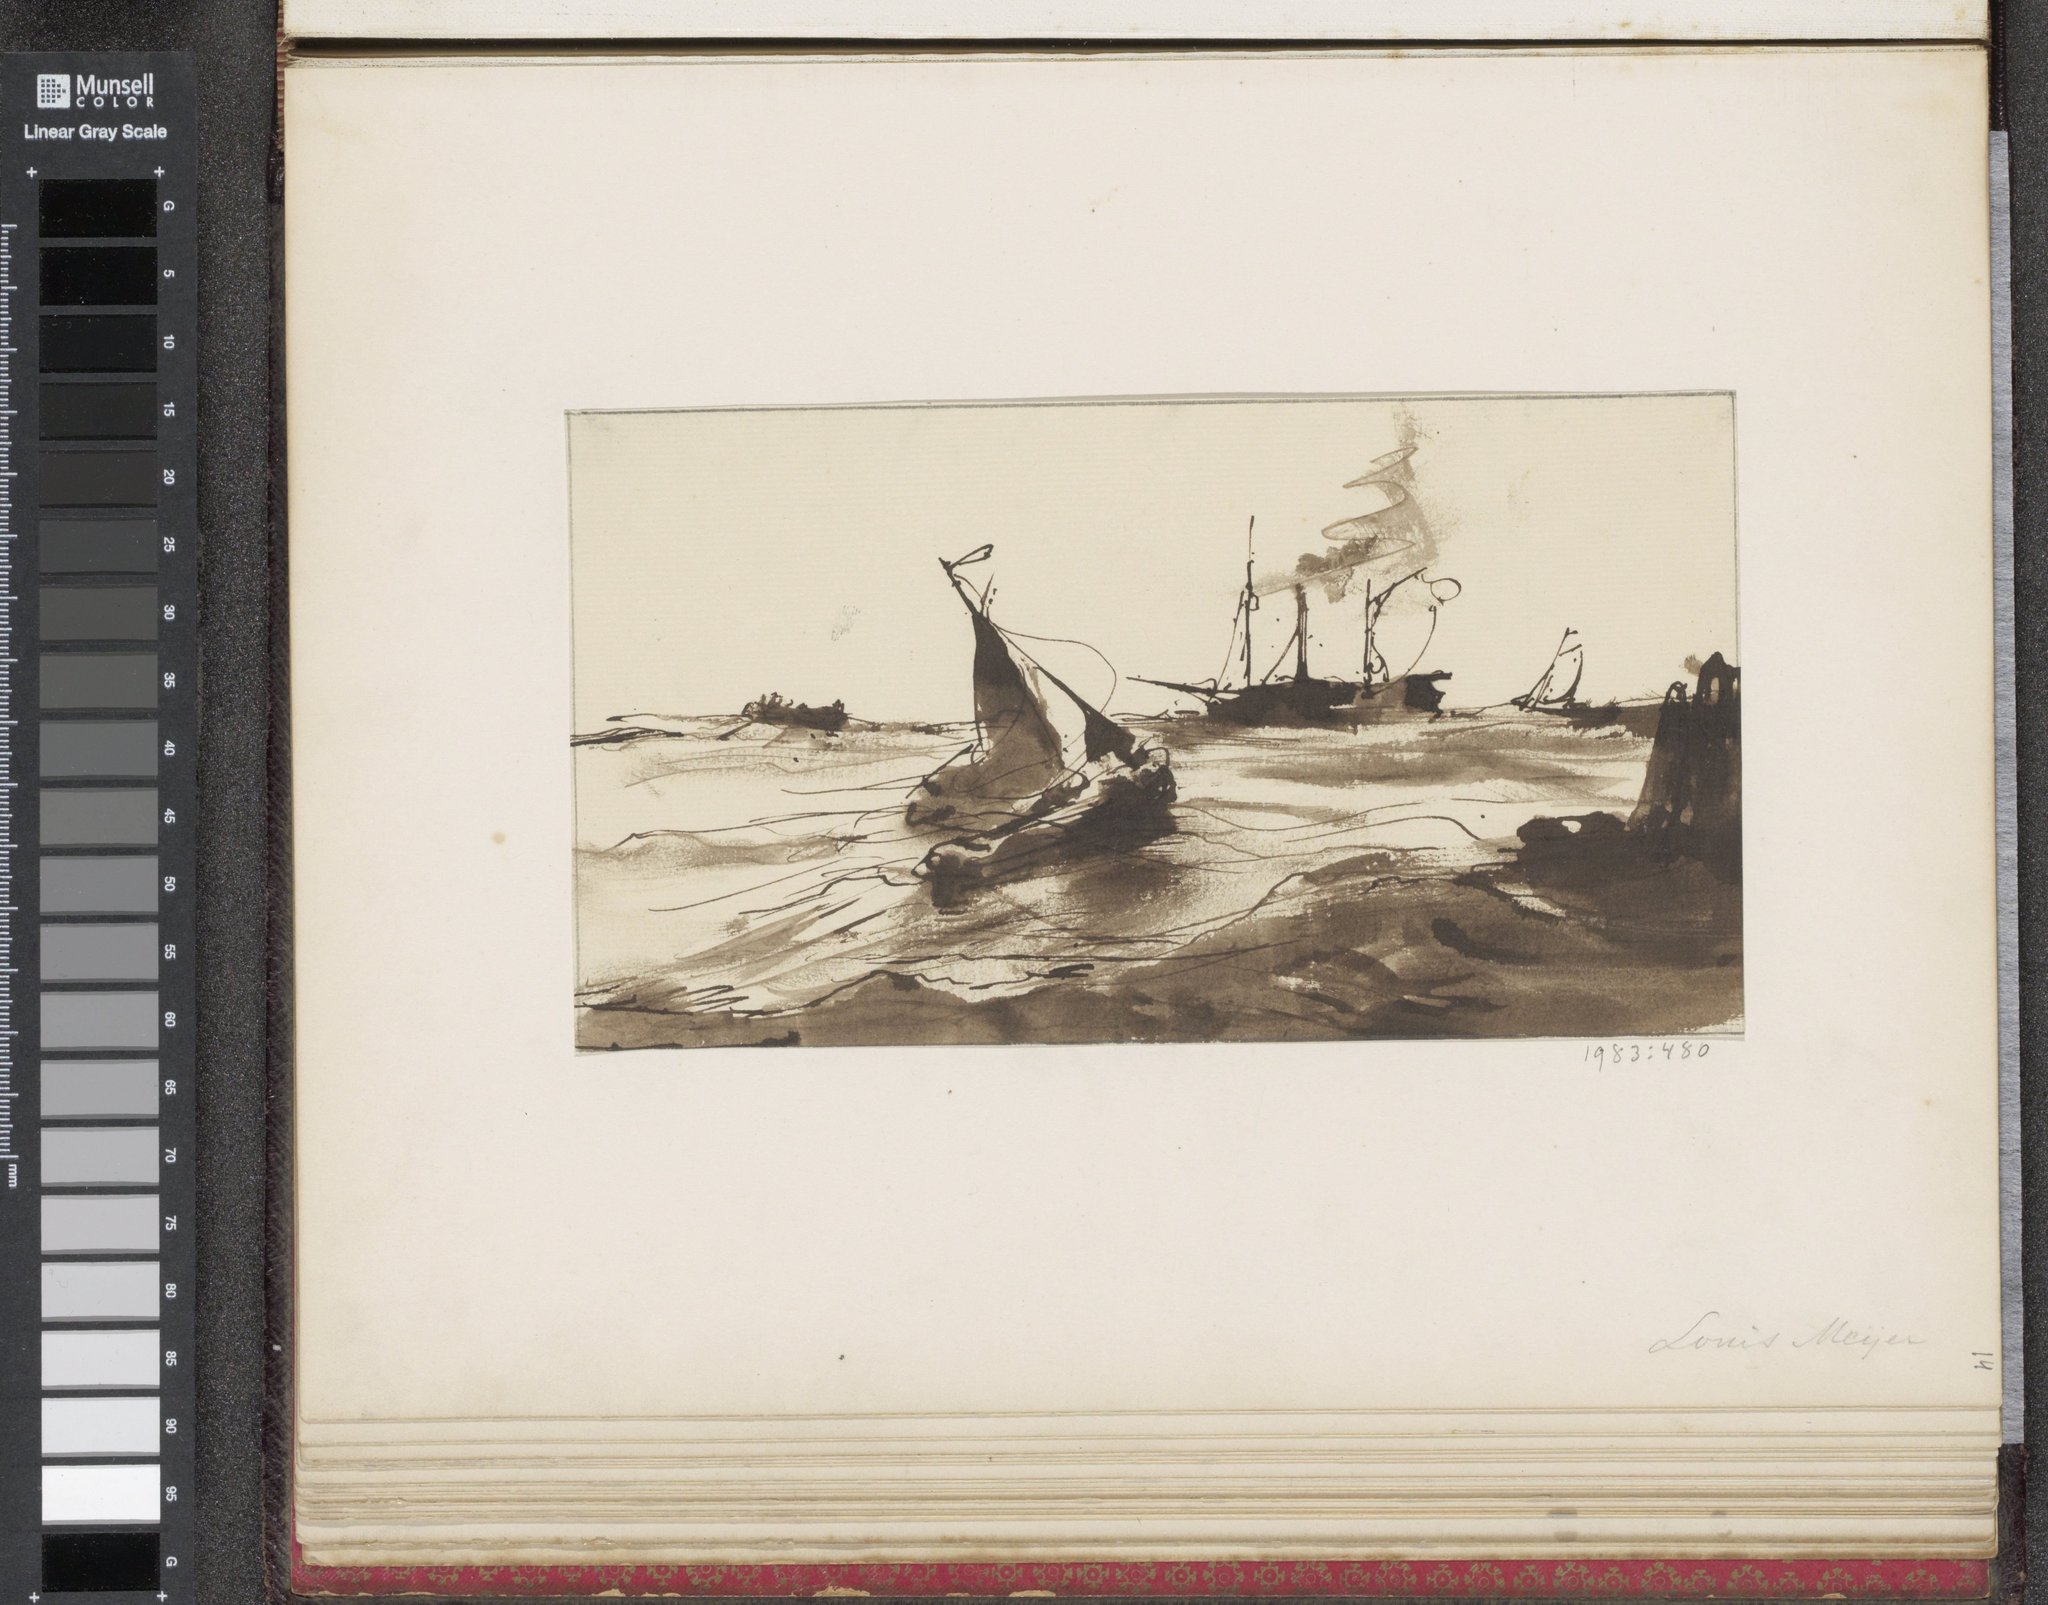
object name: drawing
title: Schepen op zee bij stormachtig weer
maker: louis meijer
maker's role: draughtsman, painter, print maker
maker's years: 1809-1866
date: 1849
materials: ink, paper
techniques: brush, pen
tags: sea (seascape), storm at sea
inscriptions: date and inscription: ‘door Louis Meyer 1849/ DB’